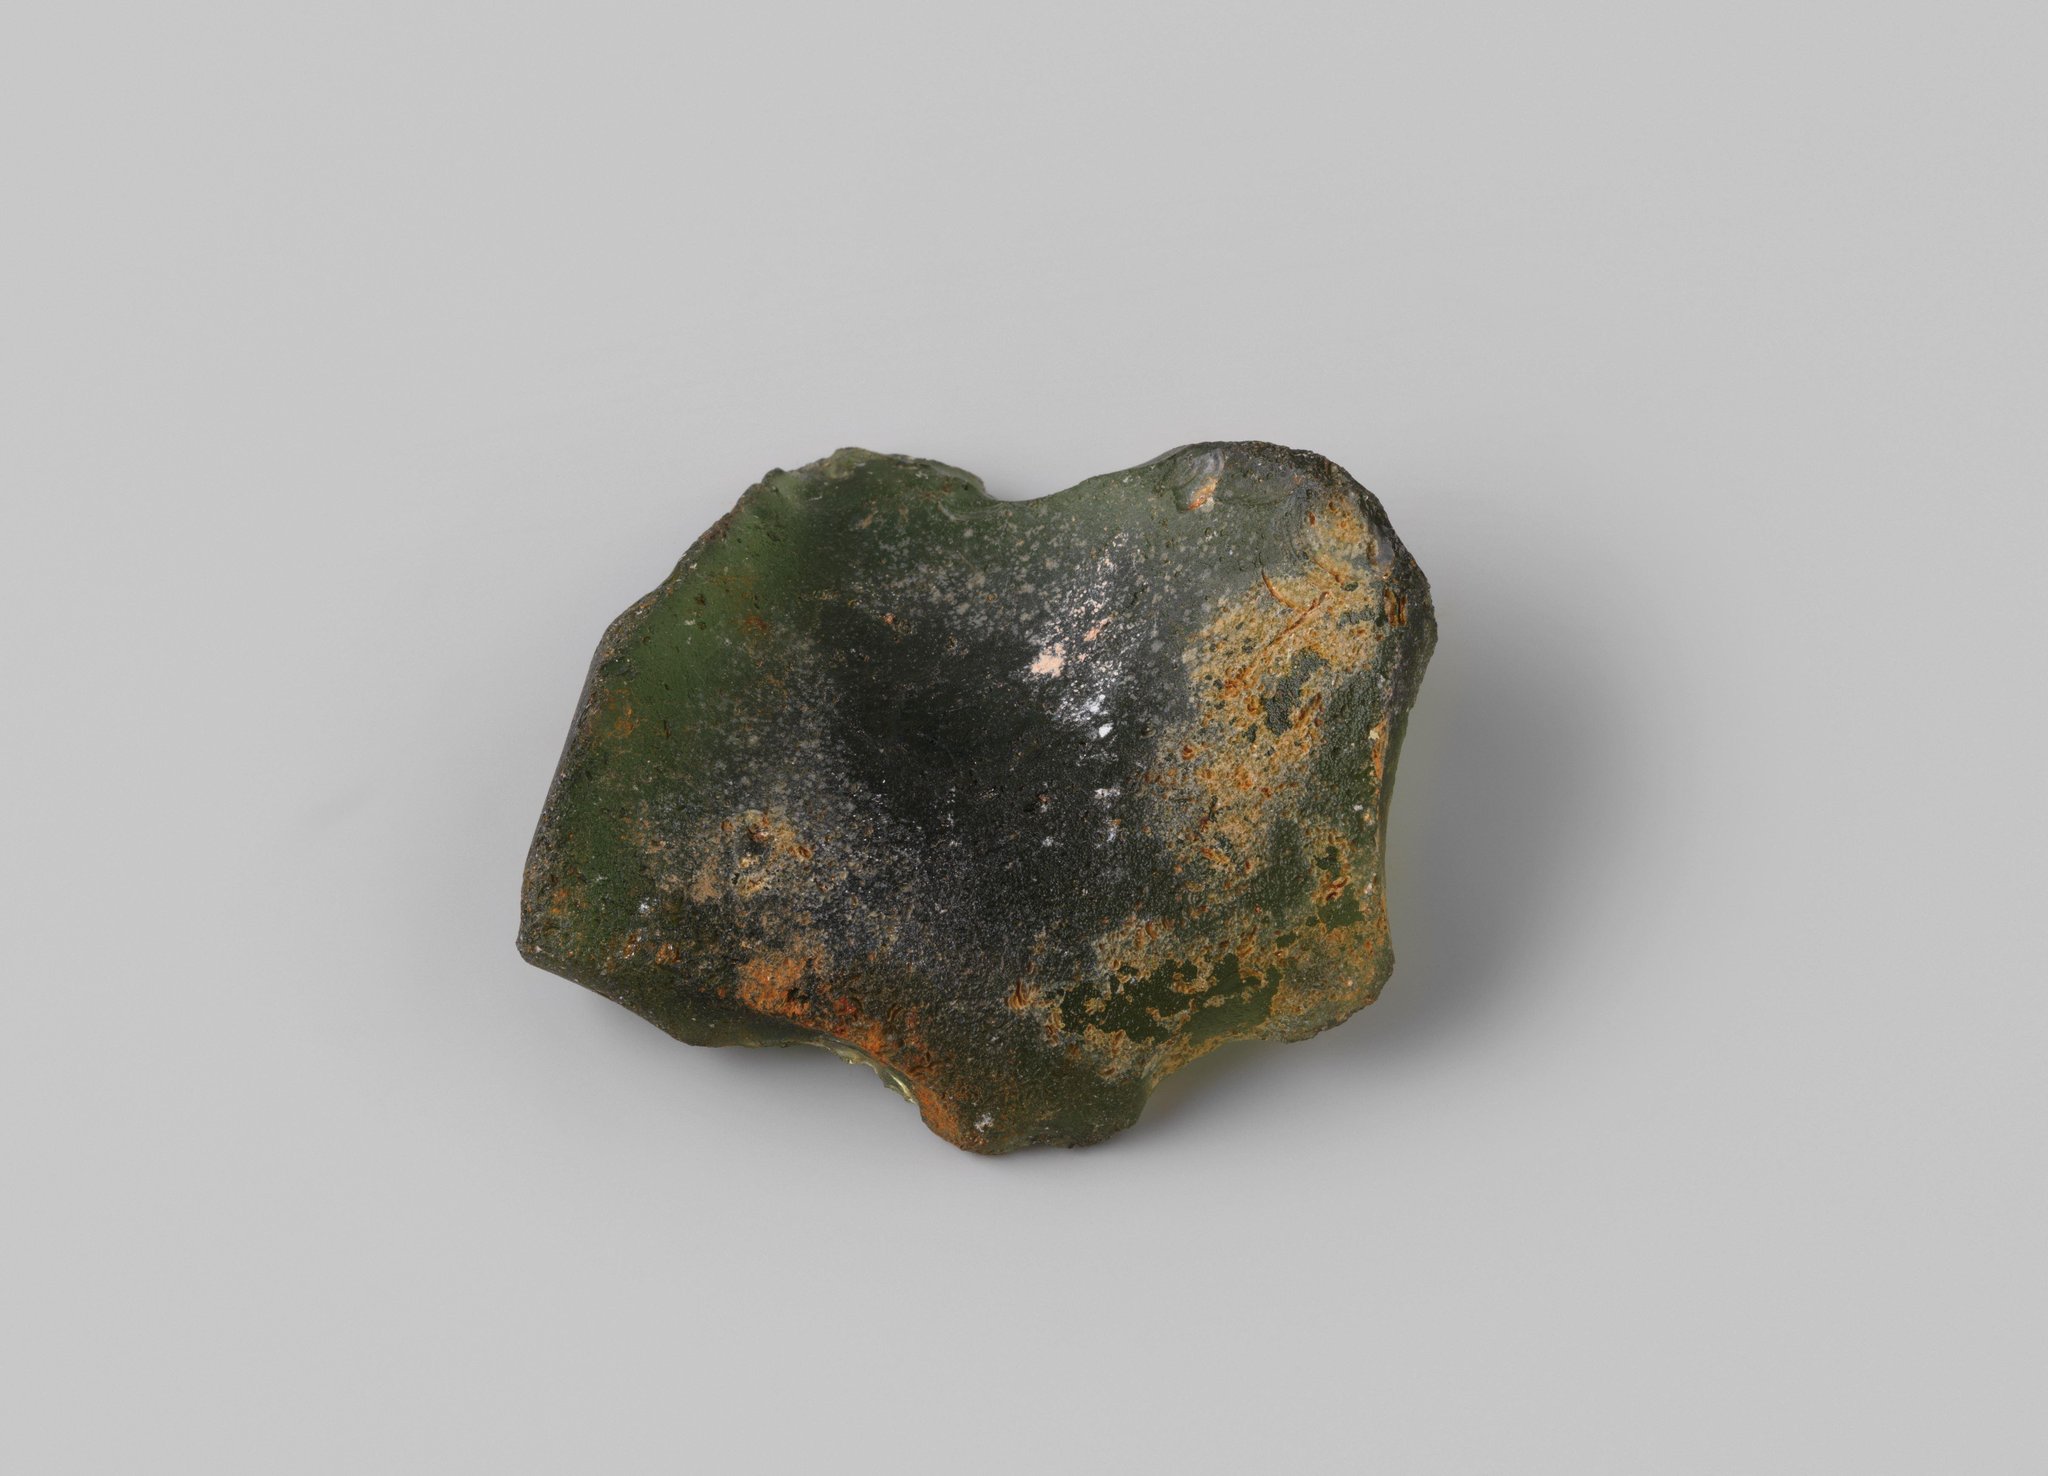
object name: wine bottle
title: Scherf van een wijnfles uit het wrak van de Oost-Indiëvaarder Hollandia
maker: Anonymous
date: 1700-1743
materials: glass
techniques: green glass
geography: netherlands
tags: verenigde oostindische compagnie, hollandia (schip), annet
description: Typologically not identifiable, base, fragm.